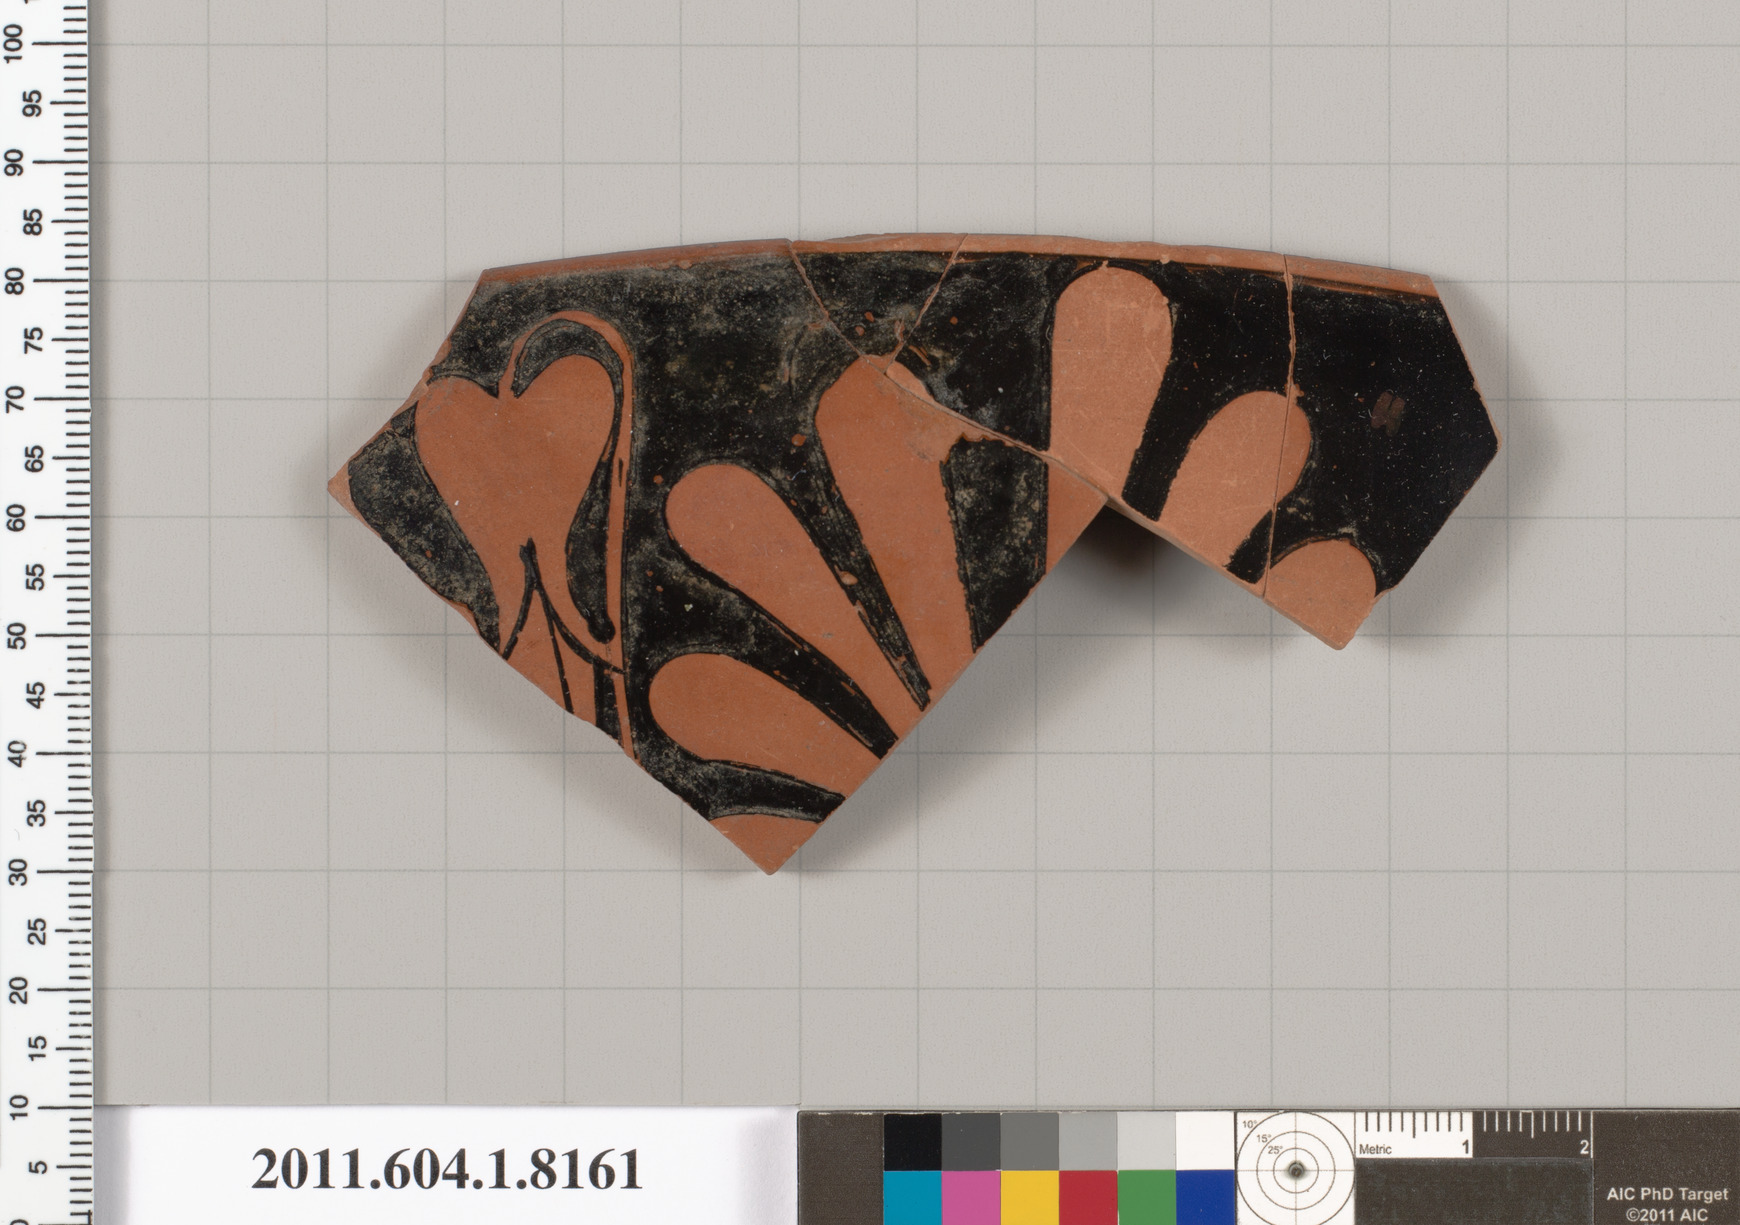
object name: kylix fragment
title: Terracotta rim fragment of a kylix (drinking cup)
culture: greek, attic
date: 520-510 BCE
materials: terracotta